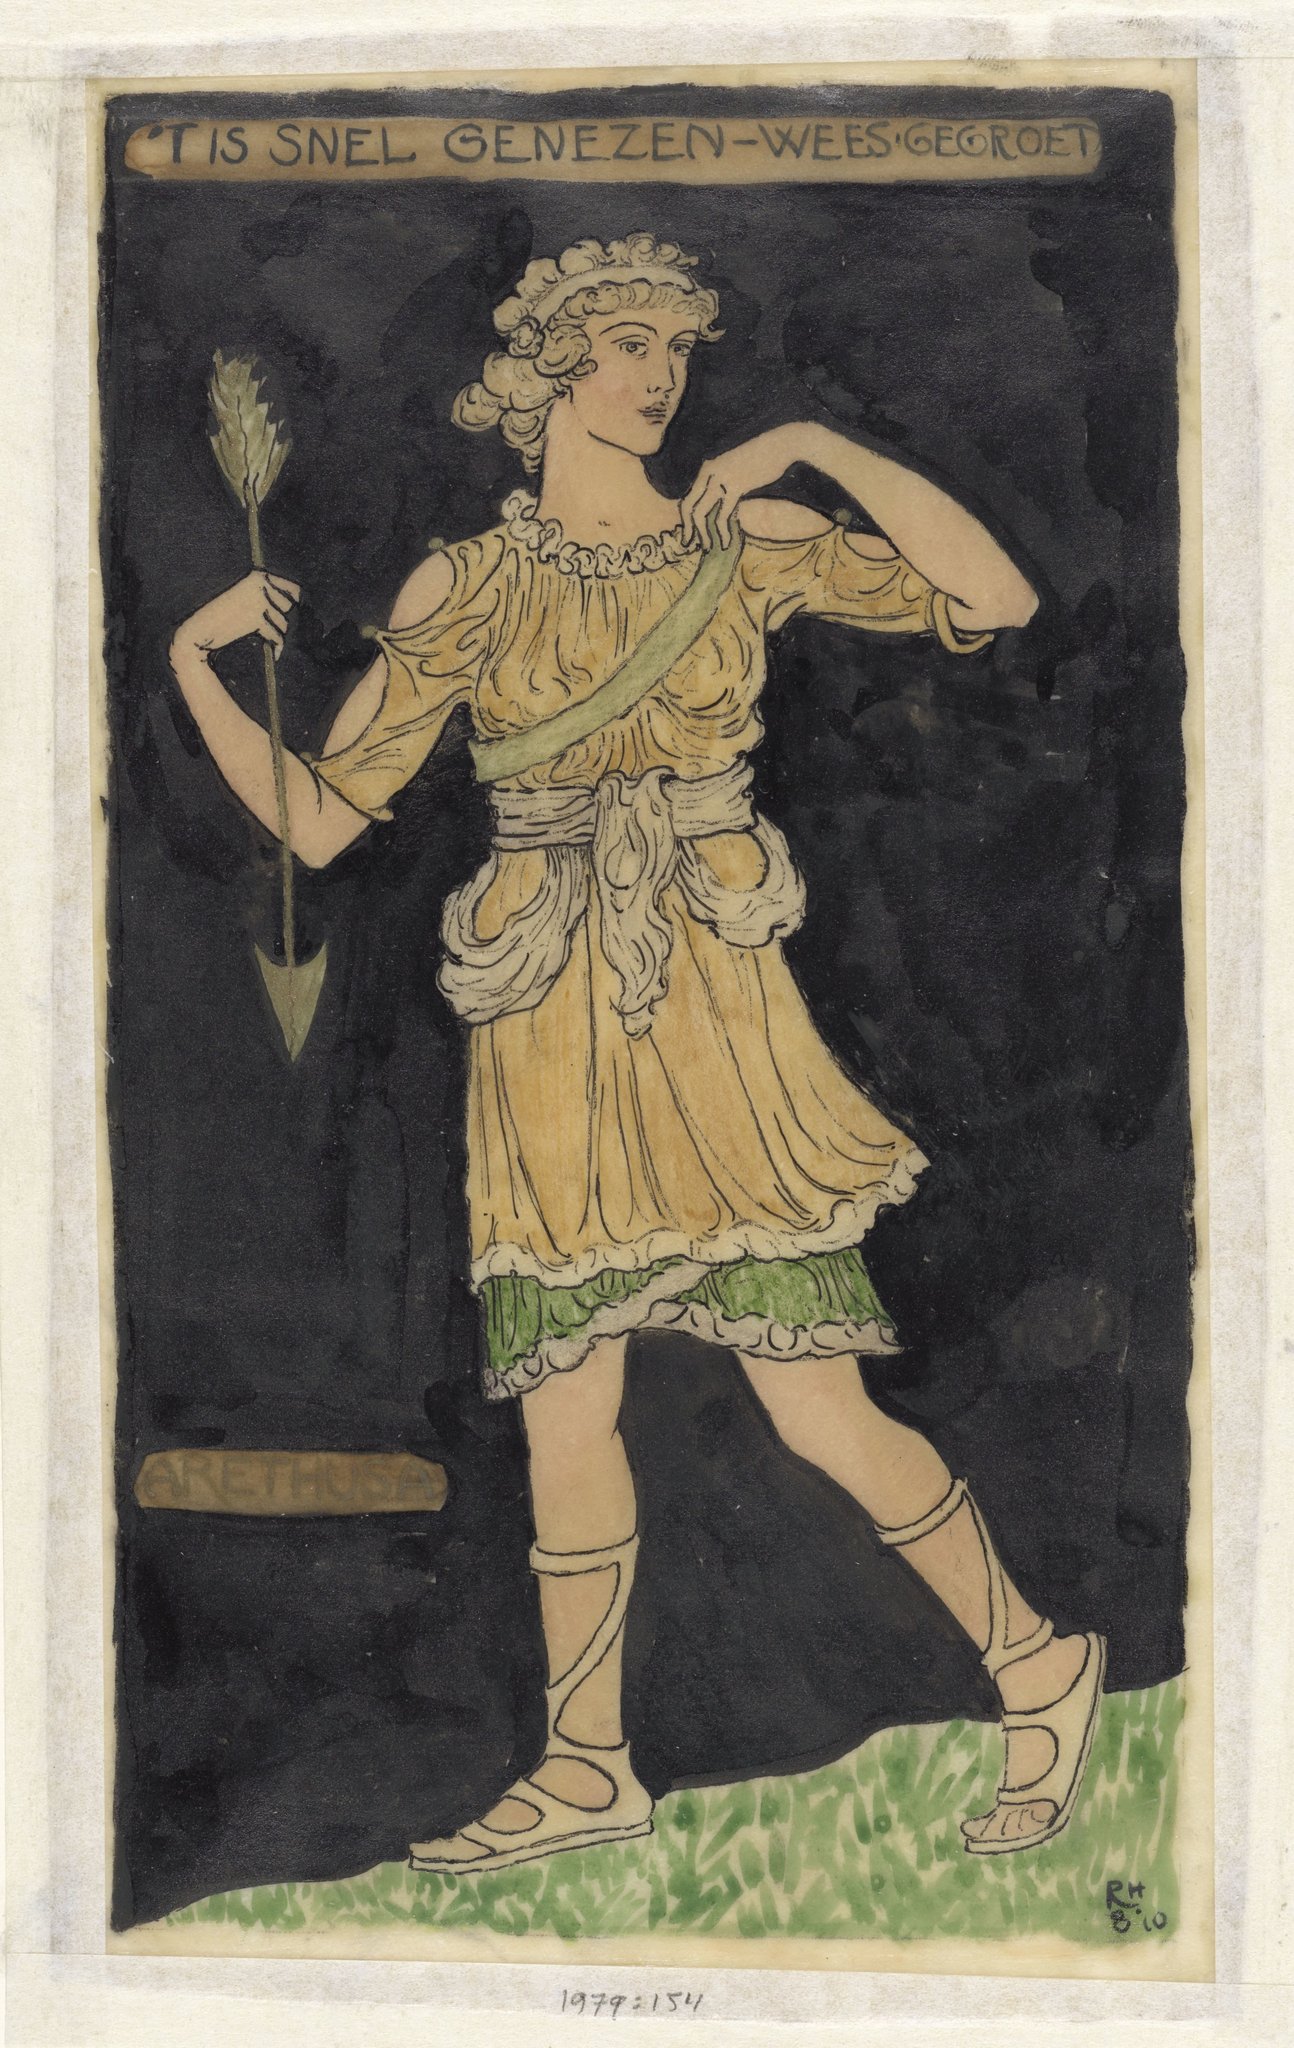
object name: design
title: Ontwerp voor kostuum voor Arethusa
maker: richard nicolaüs roland holst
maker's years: 1868-1938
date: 1908-1910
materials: paint, ink, parchment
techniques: brush, pen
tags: stage costume, female literary characters (arethusa), other nereids (or sea-nymphs): arethusa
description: Kostuumontwerp voor de nimf Arethusa, een personage uit het toneelstuk 'Marsyas' door Balthasar Verhagen.